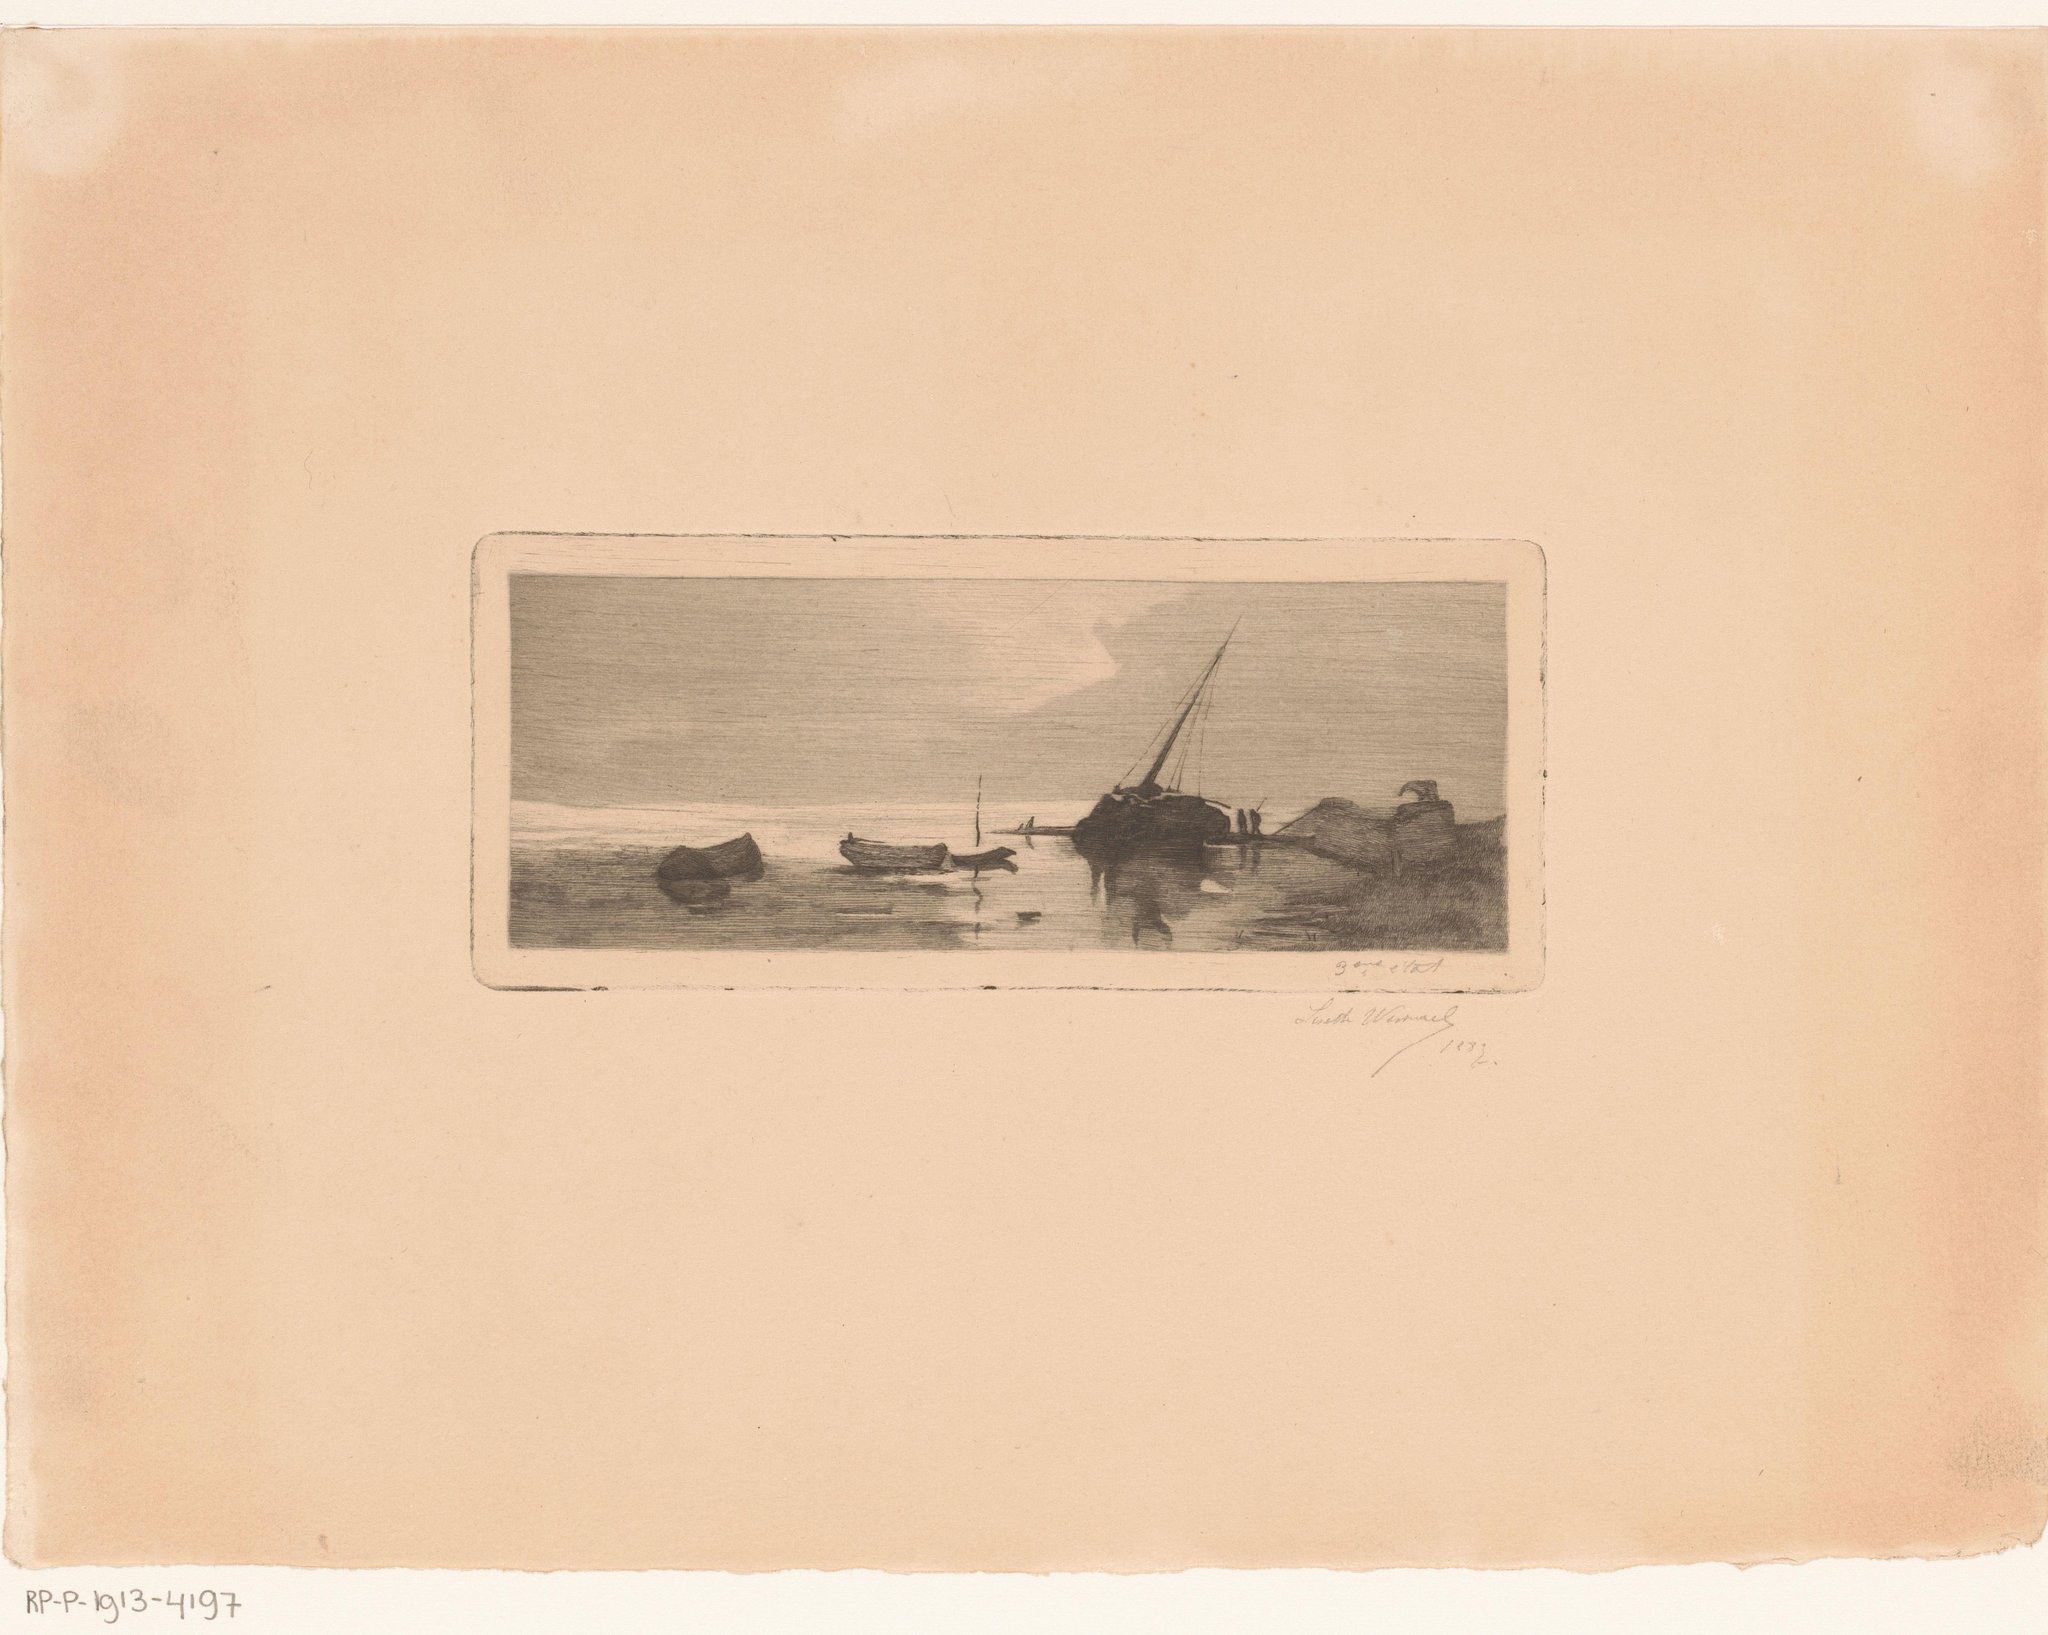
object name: print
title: Kustgezicht met twee figuren bij een schip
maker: lisette wesmael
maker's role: print maker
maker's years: 1861-1953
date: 1887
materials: paper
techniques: drypoint, etching, intaglio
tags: ships (in general), sea (seascape), coast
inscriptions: collector's mark: Lugt 2228